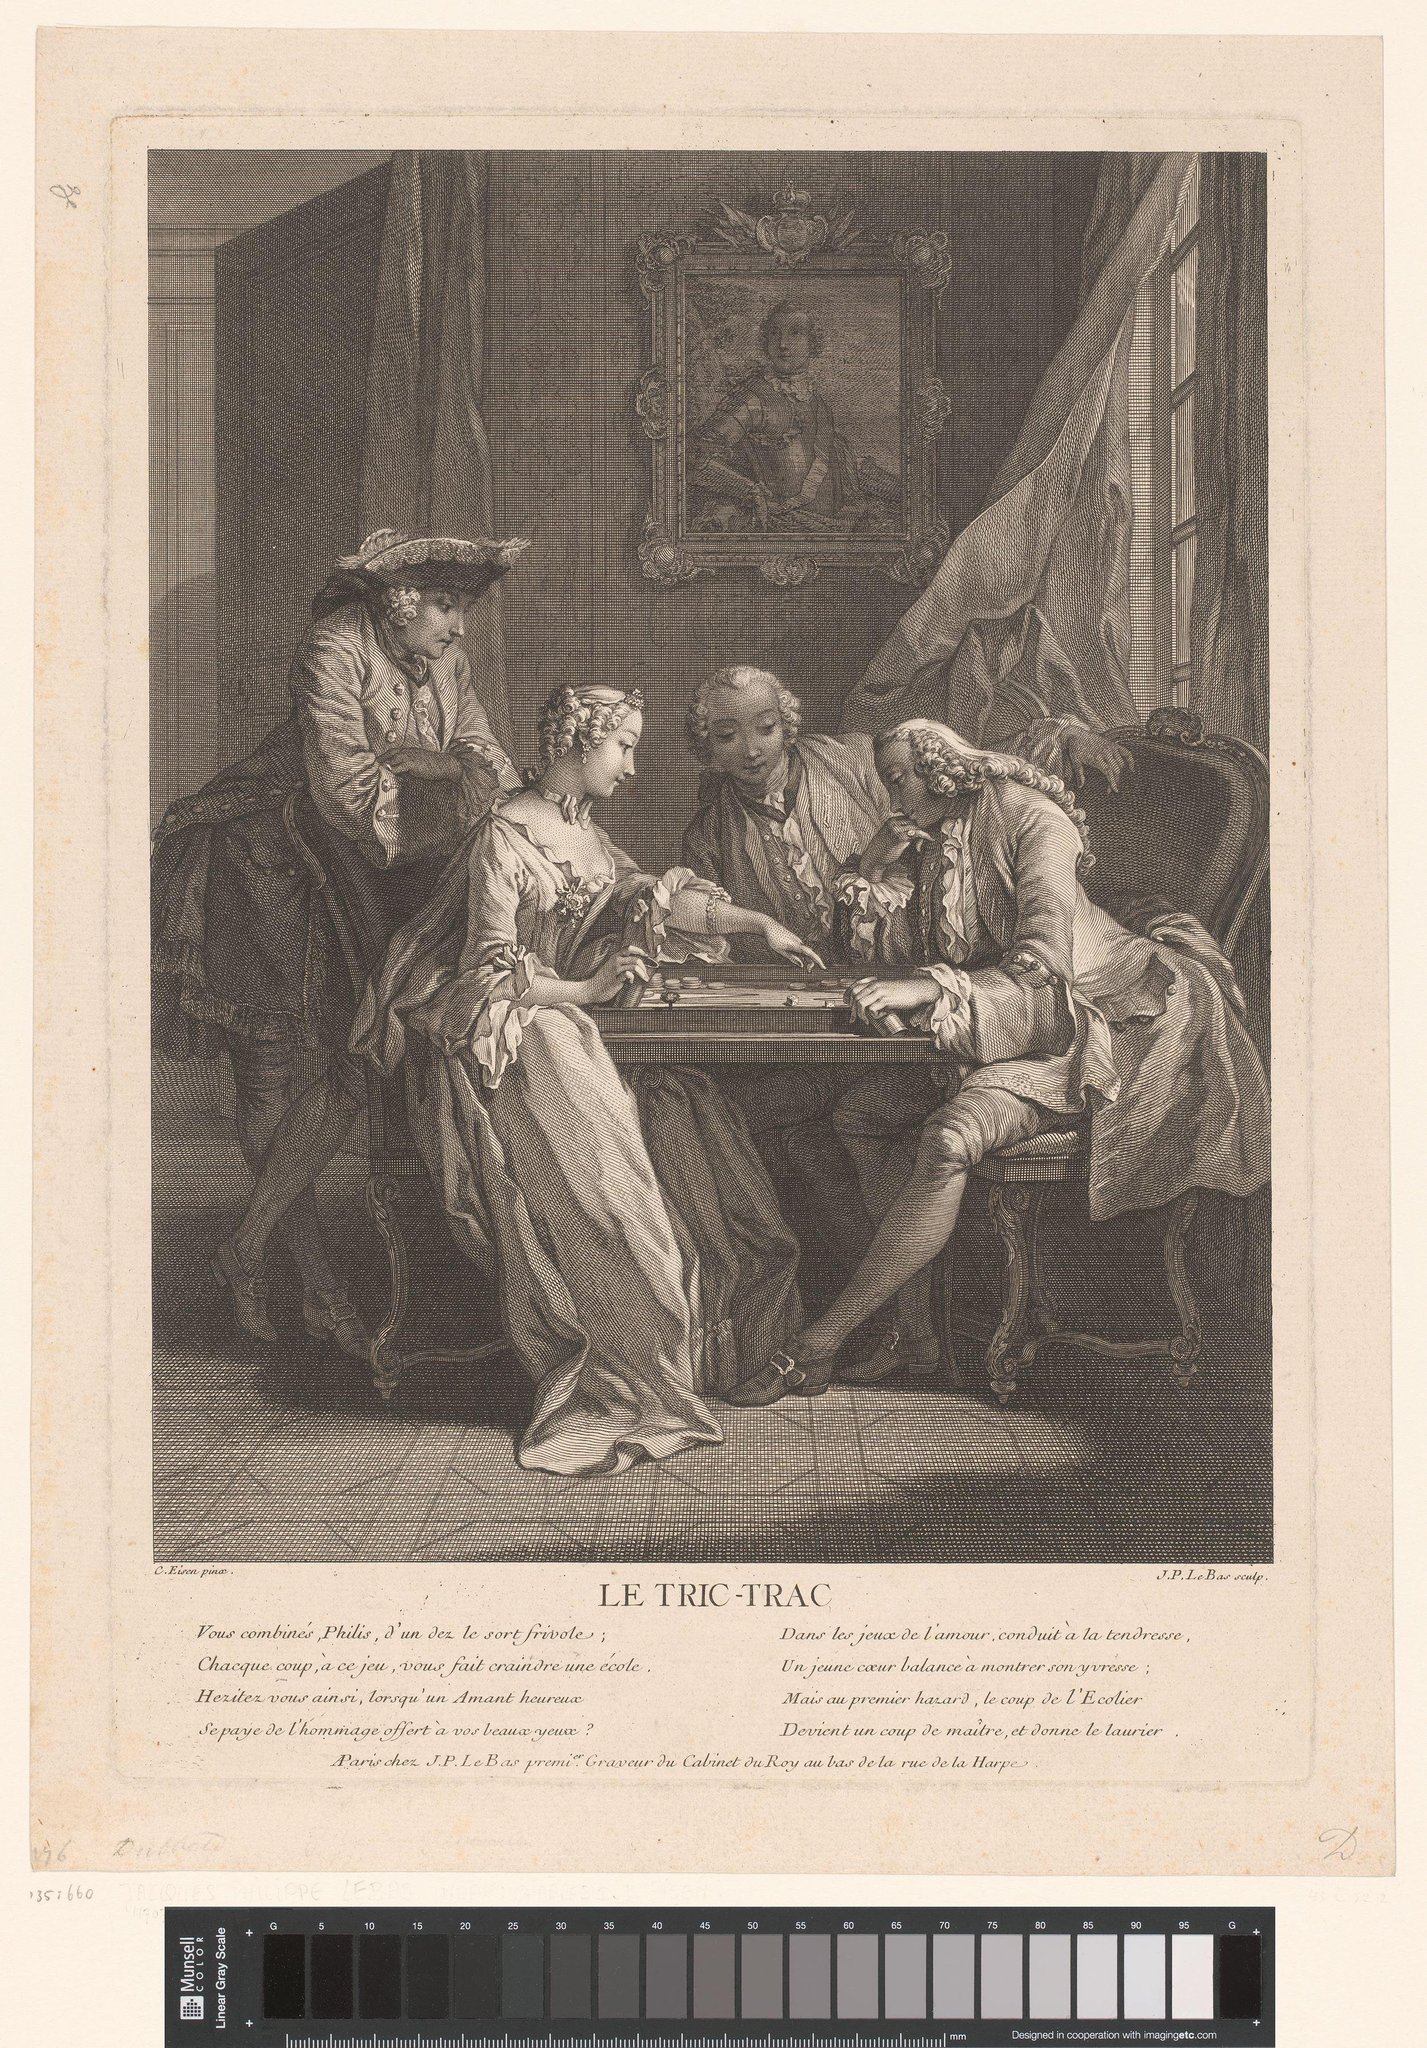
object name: print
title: Le Tric-Trac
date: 1730-1783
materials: paper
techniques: engraving, etching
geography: paris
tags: drawing-room, 'salon', picture within picture, clothes, costume (+ men's clothes), backgammon, tric-trac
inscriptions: collector's mark: Lugt 2228